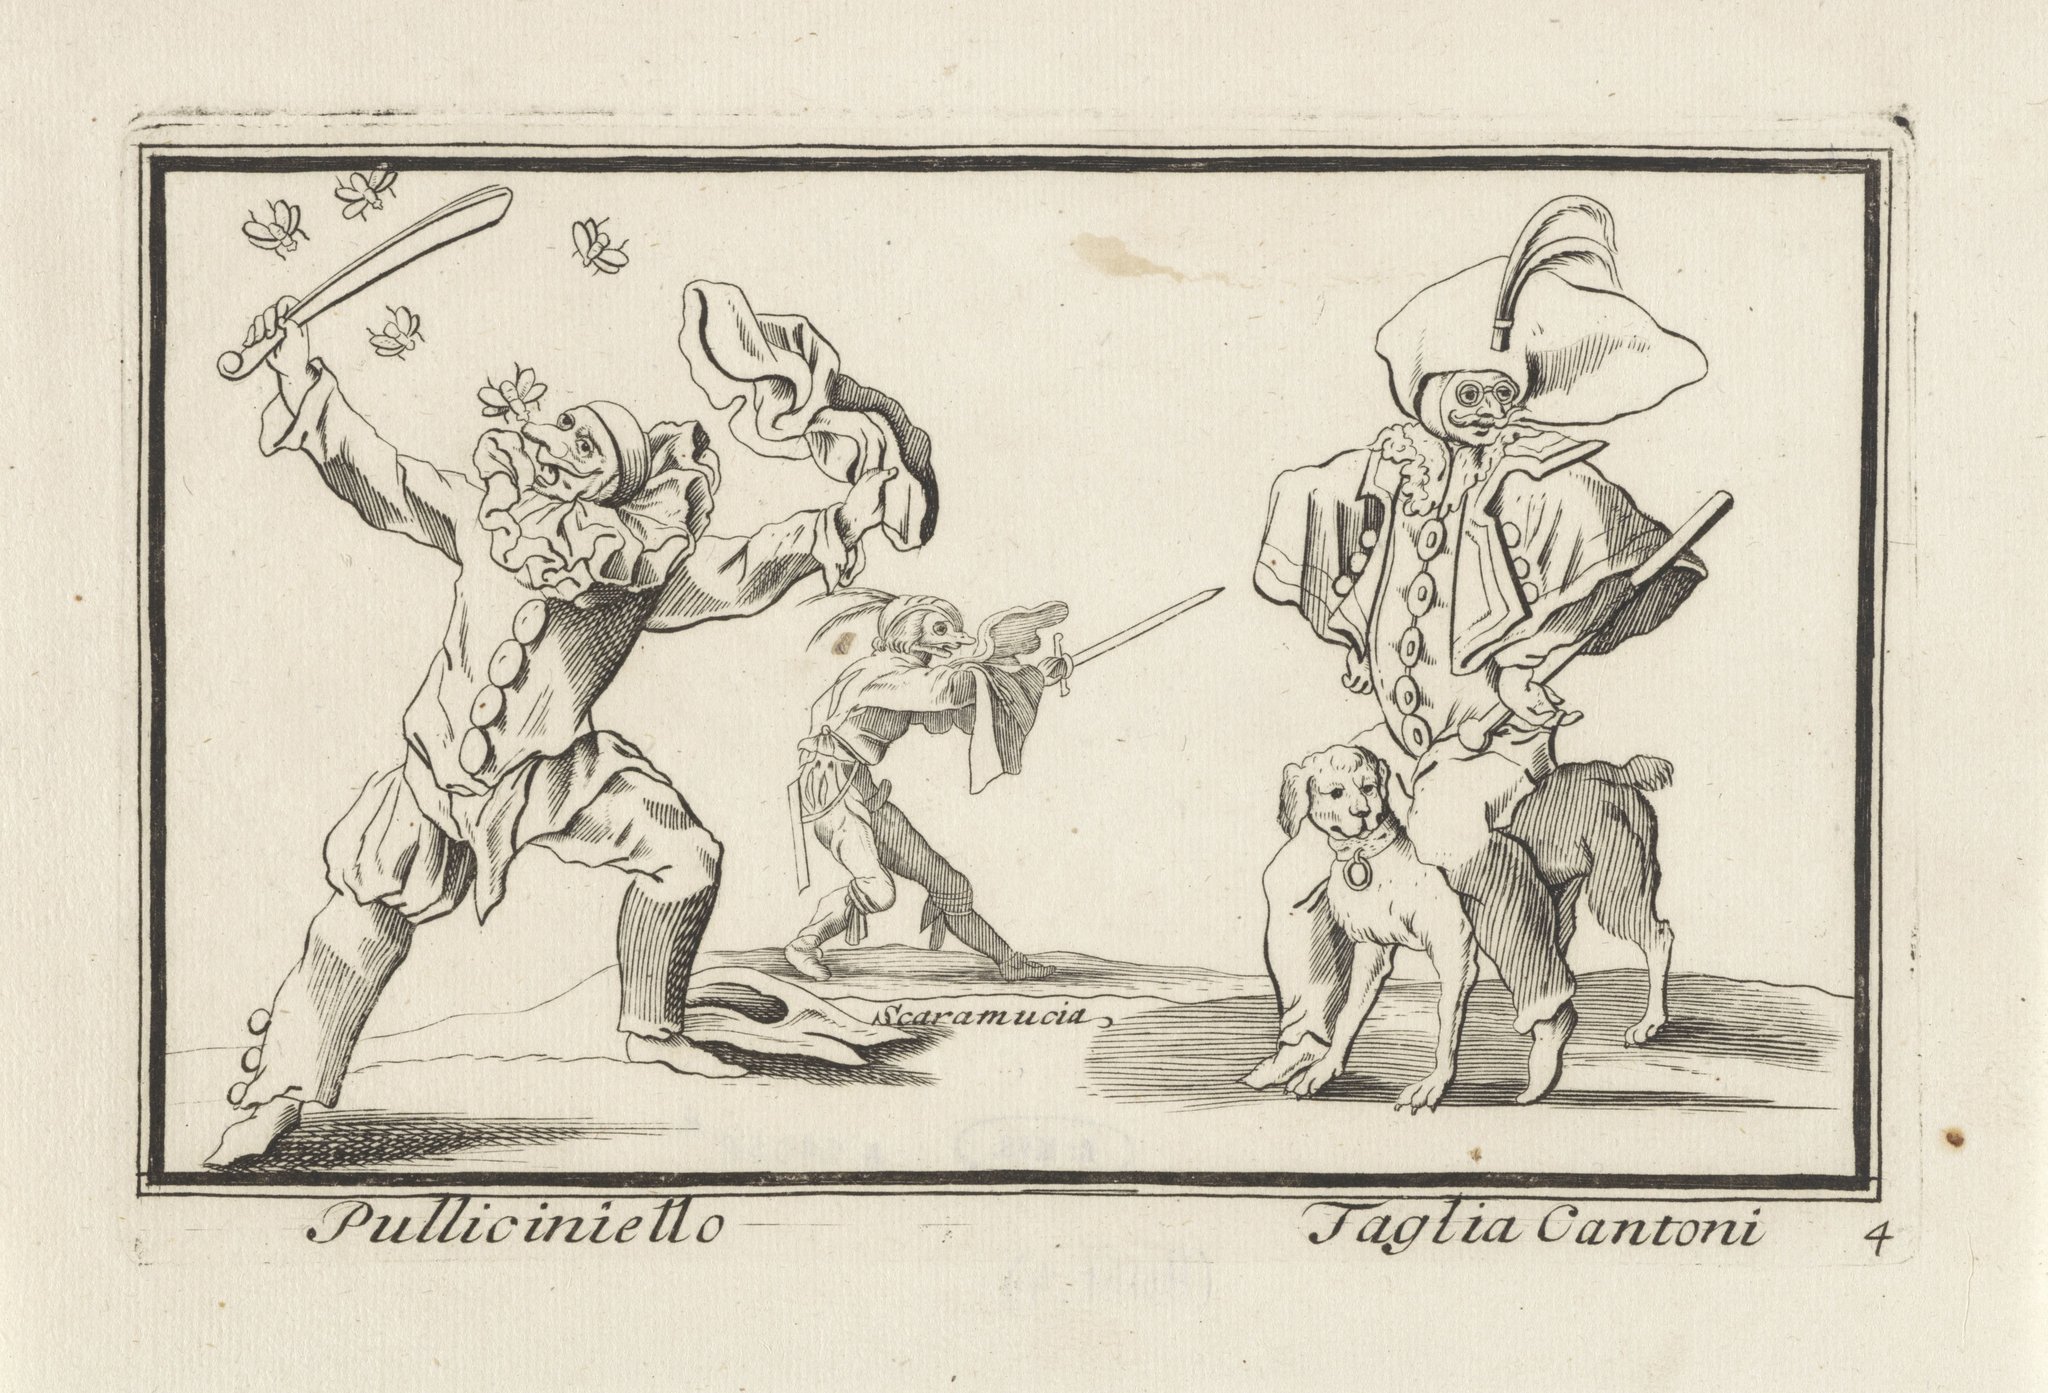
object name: print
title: Pulliciniello Scaramucia Taglia Cantoni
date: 1668-1707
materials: paper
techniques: etching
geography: amsterdam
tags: types in 'commedia dell'arte', types in 'commedia dell'arte': pulcinella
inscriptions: collector's mark: Lugt 2228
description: Drie personages uit de commedia dell'arte. Links Pulcinella die vliegende insecten probeert te verjagen. In het midden Scaramouche met een zwaard. Rechts zit Taglia Cantoni op een hond.